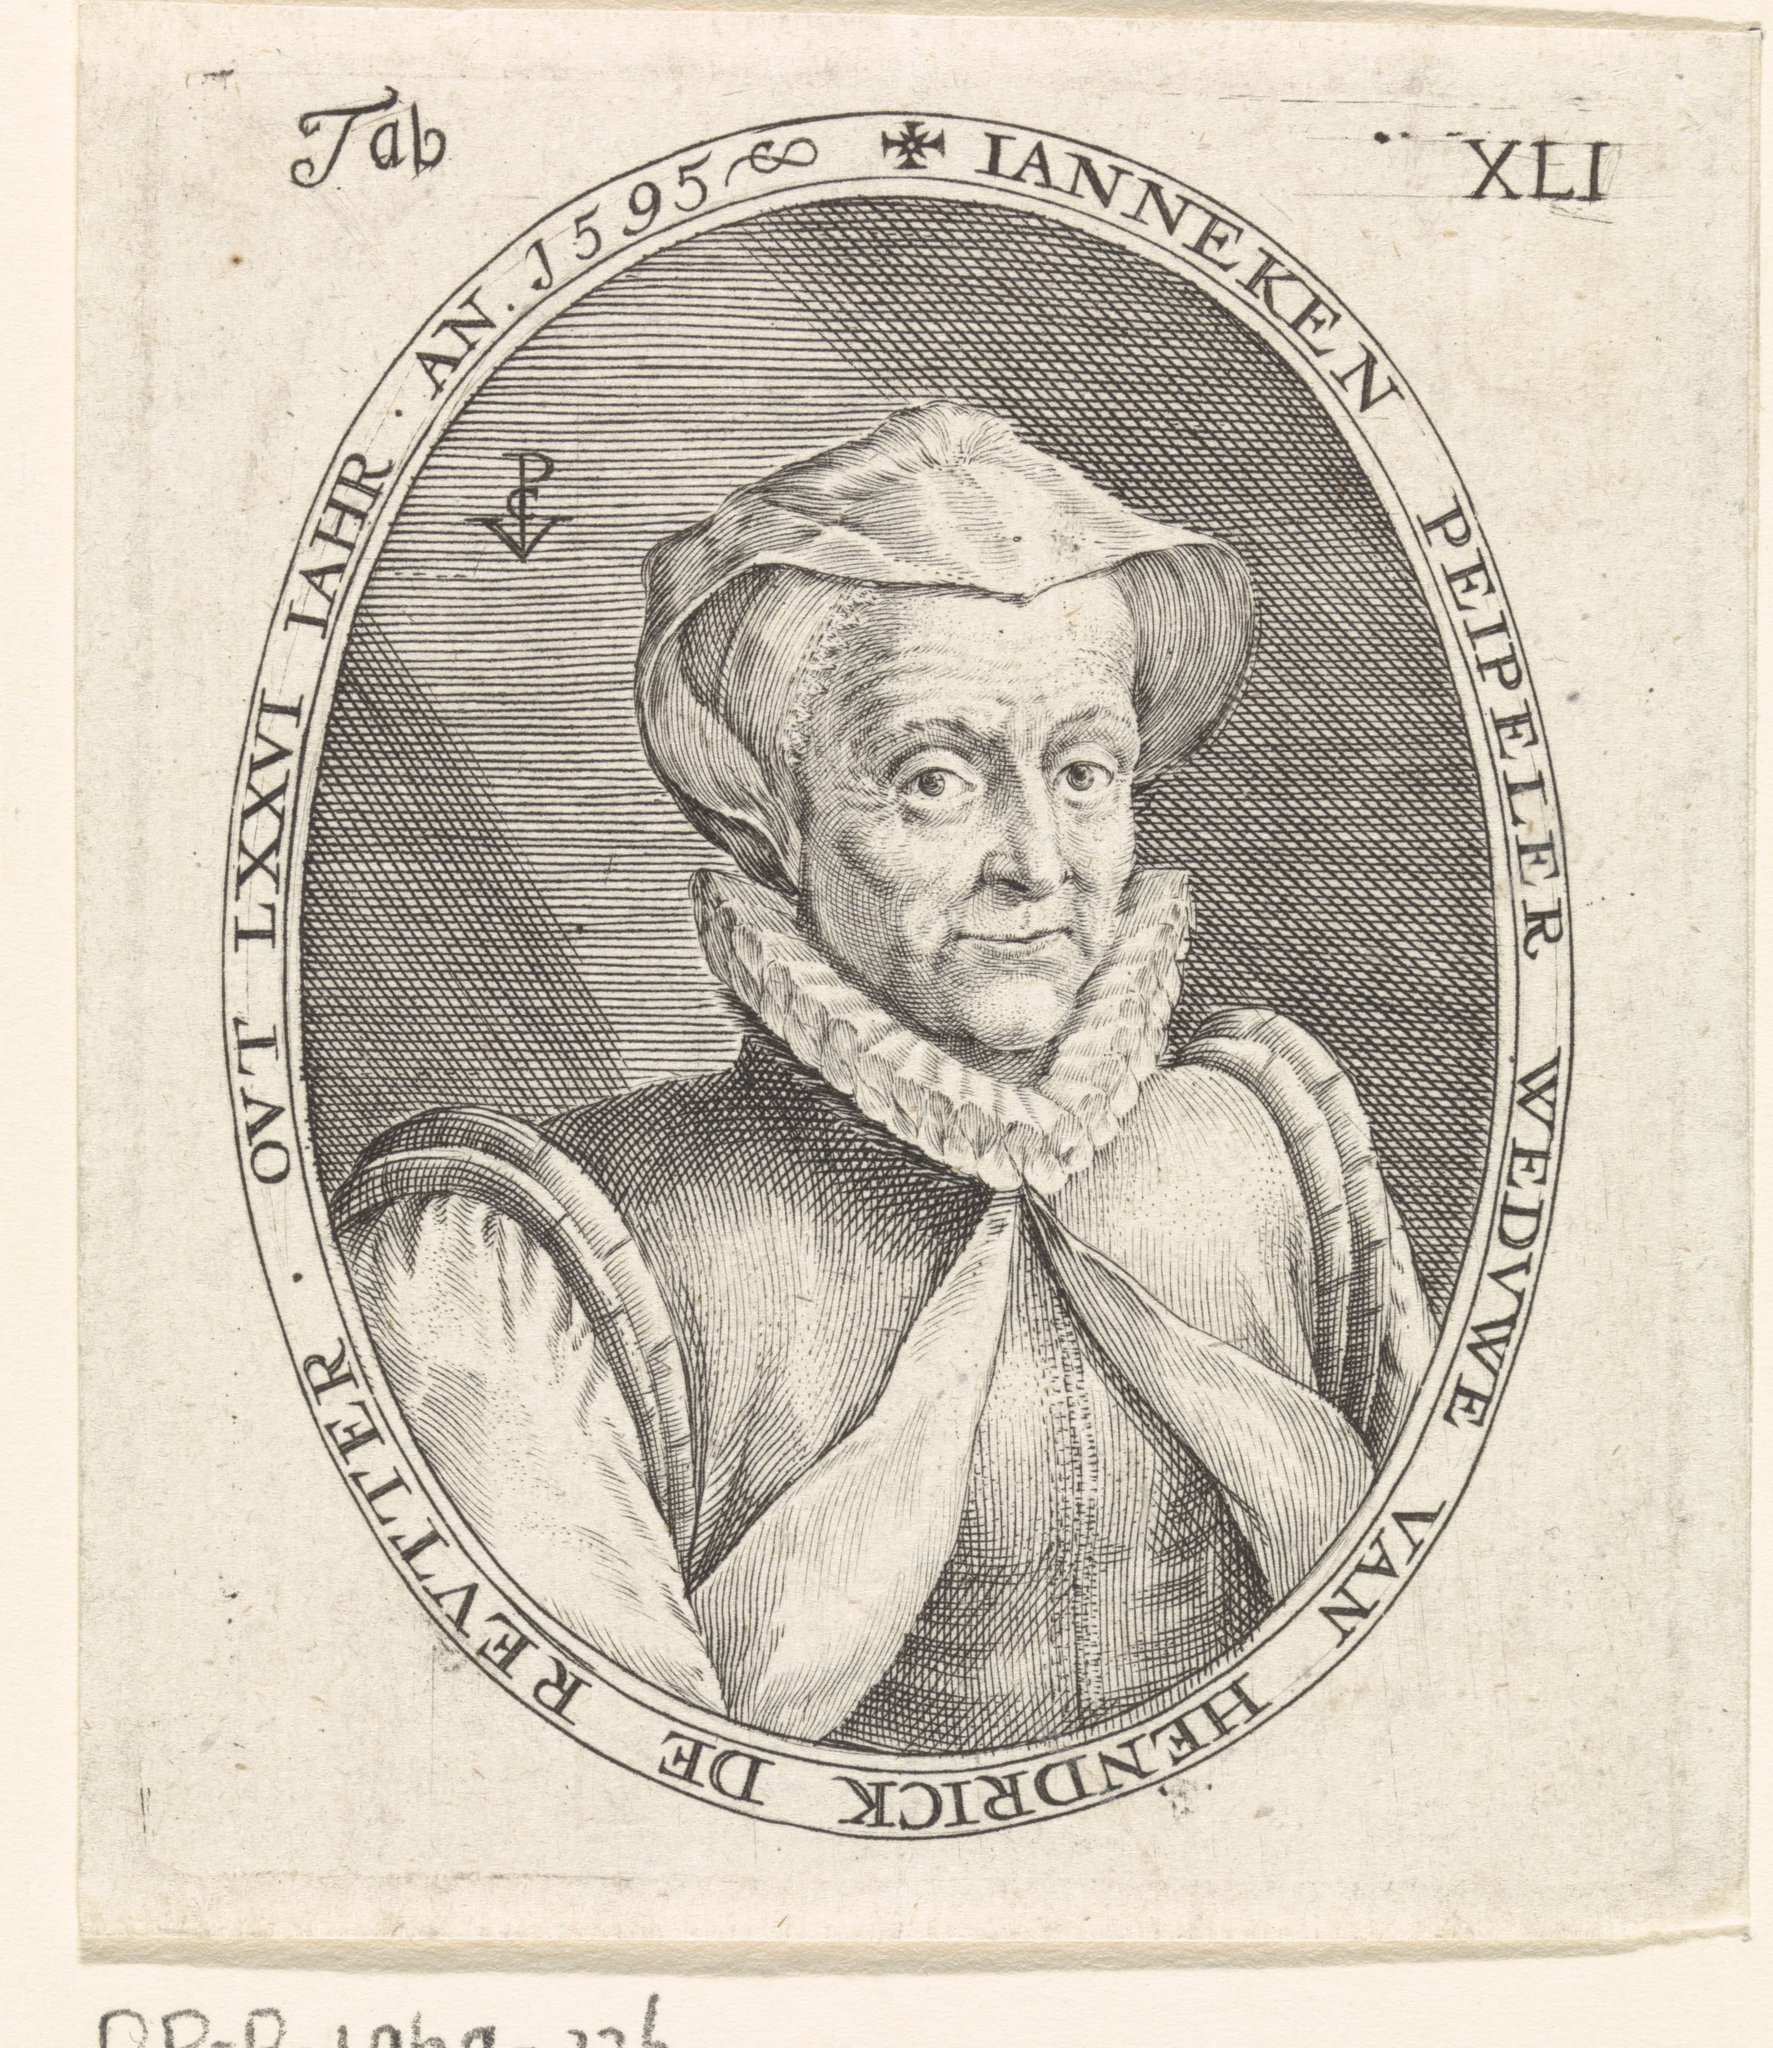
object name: print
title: Portret van Janneke Peipeler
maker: crispijn van de passe (i)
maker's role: draughtsman, print maker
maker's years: 1564-1637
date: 1595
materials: paper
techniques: engraving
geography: cologne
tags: janneke peipeler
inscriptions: collector's mark: Lugt 2228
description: Portret van Janneke Peipeler, weduwe van de predikant Hendrik de Reutter, op 76-jarige leeftijd.